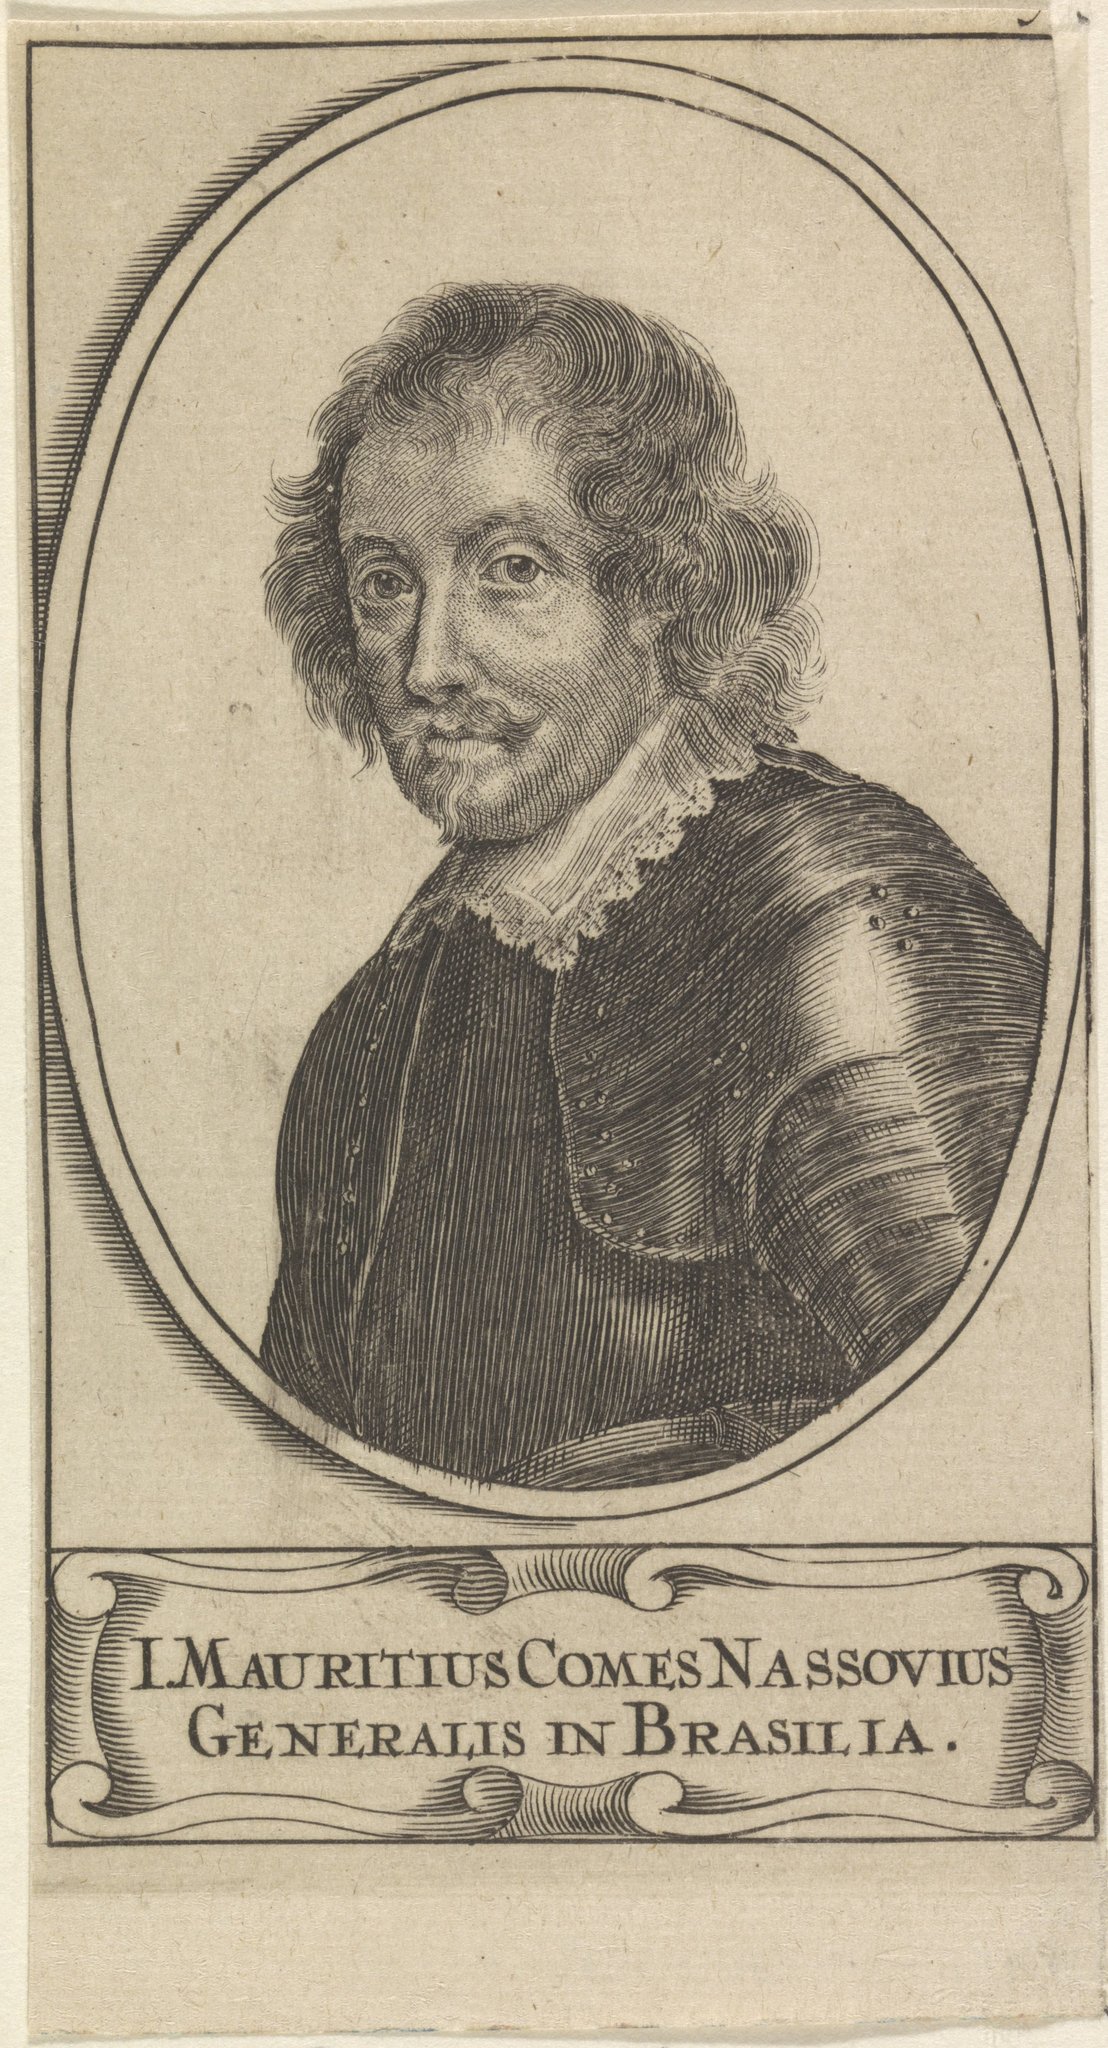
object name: print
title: Portret van Johan Maurits, graaf van Nassau-Siegen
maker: Anonymous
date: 1625-1699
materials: paper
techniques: engraving, etching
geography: low countries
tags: earl, johan maurits graaf van nassau-siegen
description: De hier vermelde titel verwijst naar de hoogst verkregen titel van de geportretteerde, niet per se naar de titel die de geportretteerde op deze voorstelling draagt.